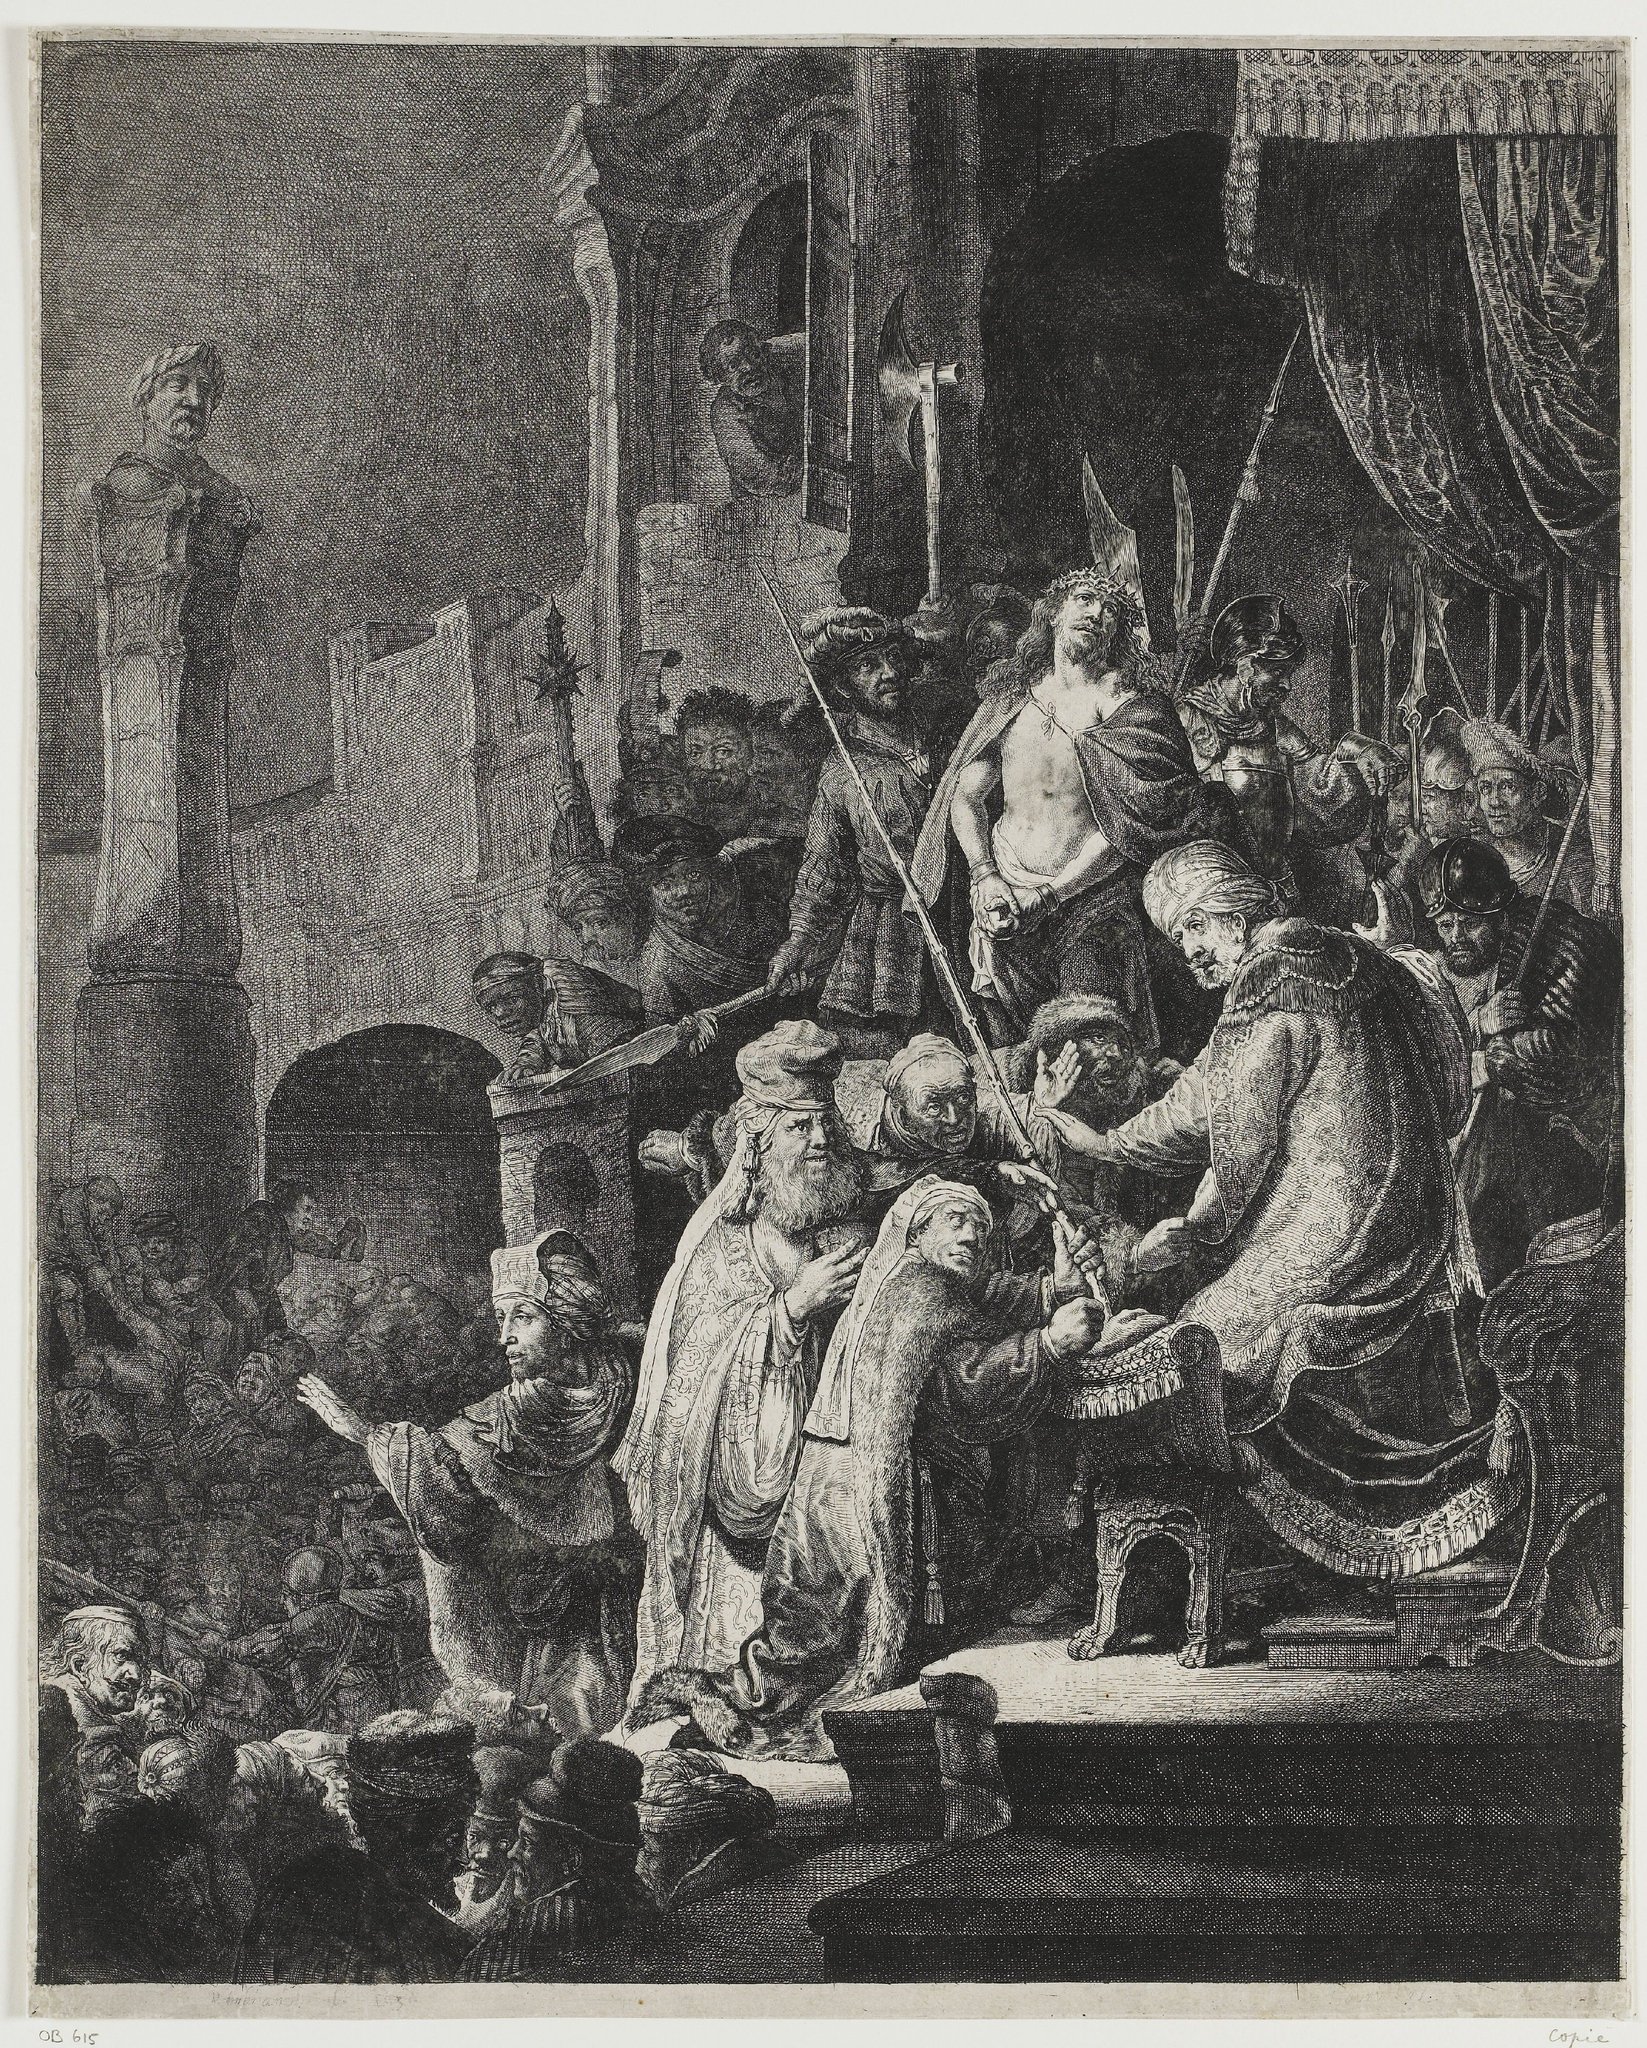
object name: print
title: Christ before Pilate: large plate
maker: Anonymous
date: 1740-1778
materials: paper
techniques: etching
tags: christ before pontius pilate (matthew 27:11-26; mark 15:2-15; luke 23:2-7, 23:13-25; john 18:28 - 19:16)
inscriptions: signature and date: ‘Rembrandt f 1636’, collector's mark: Lugt 240